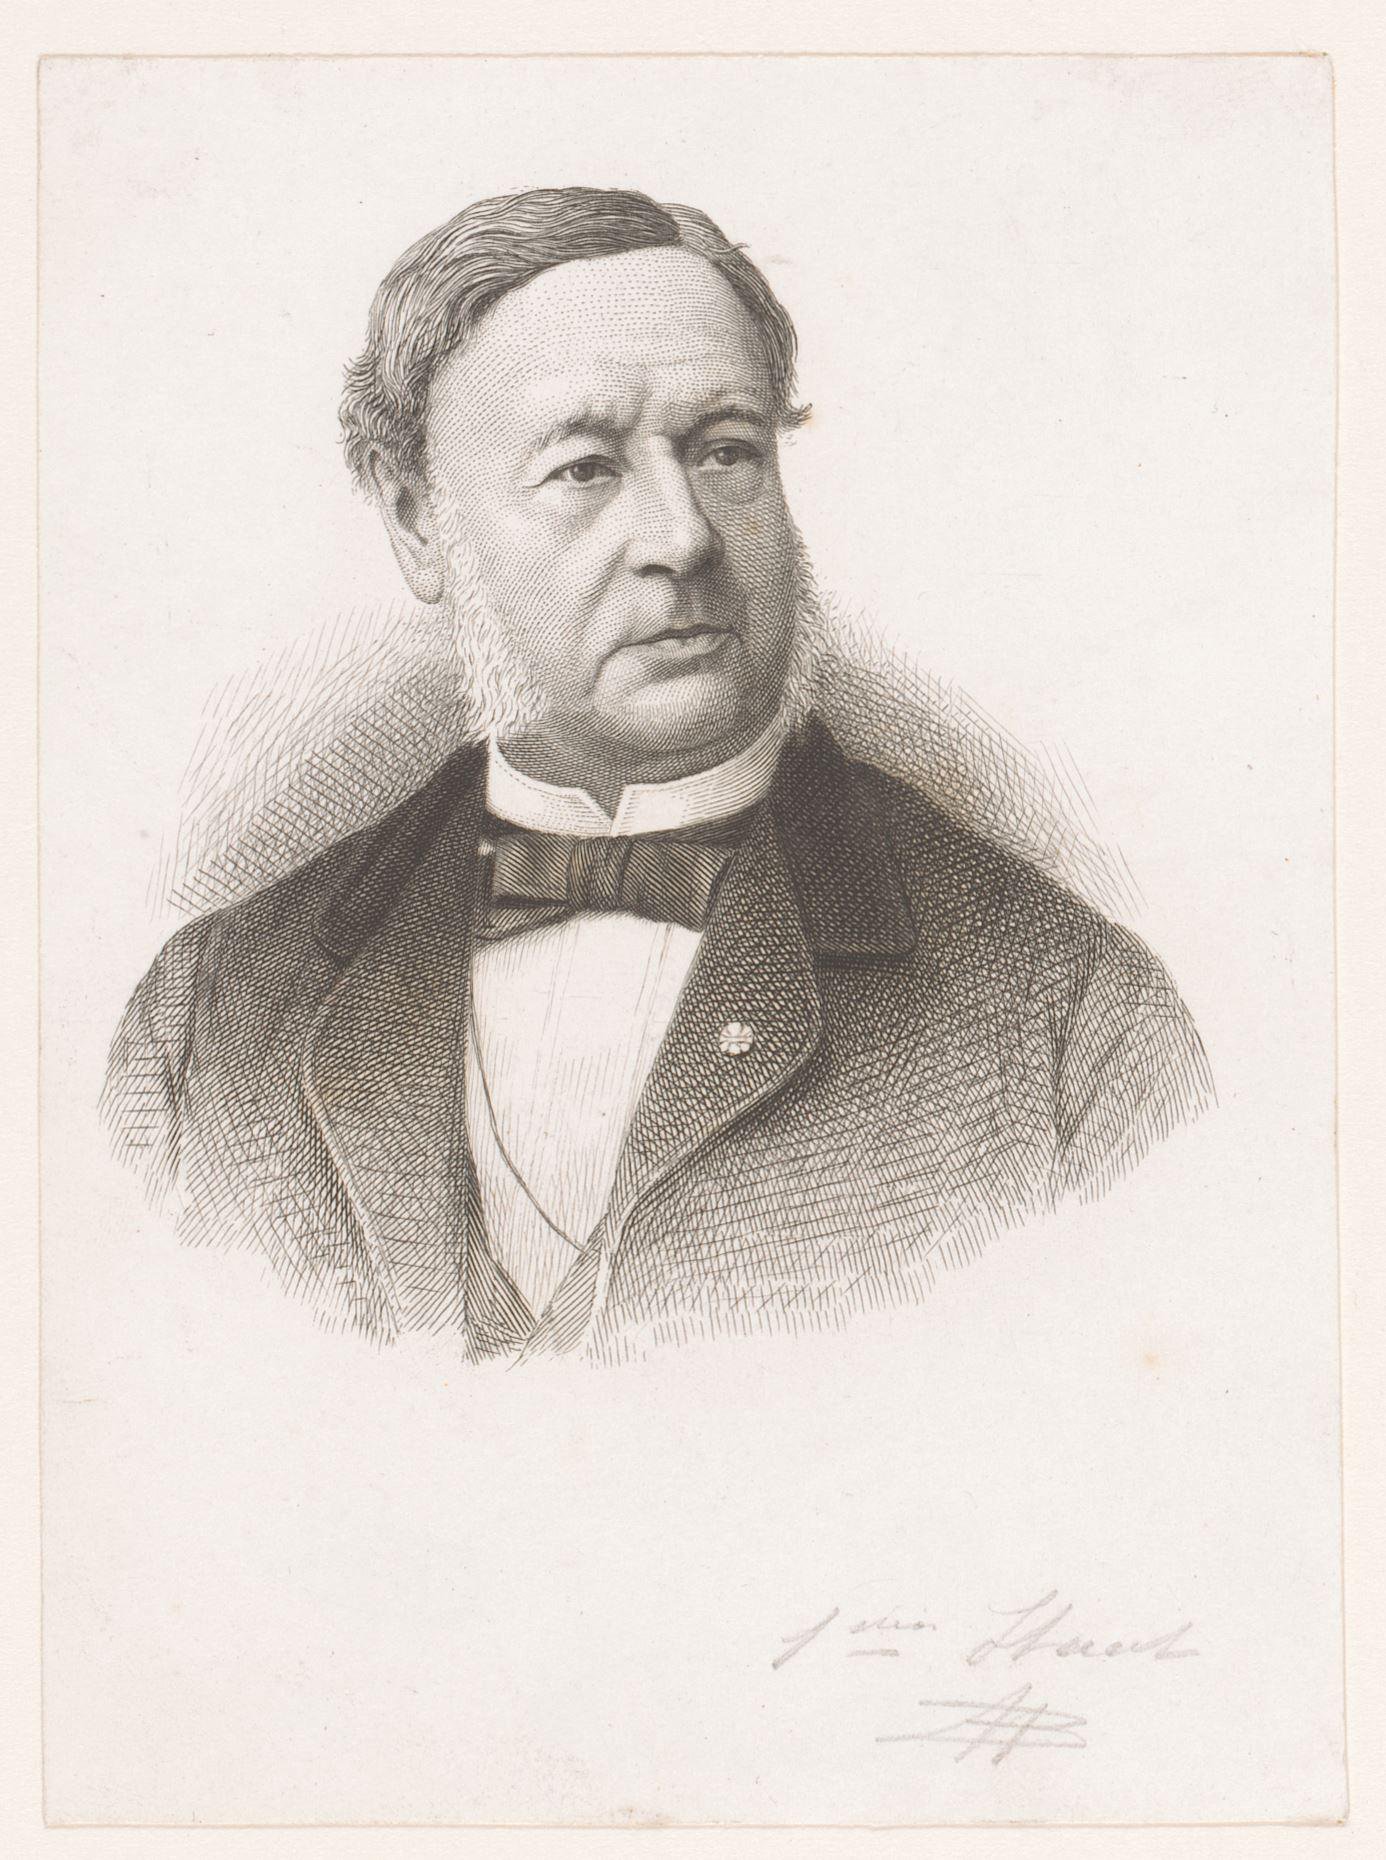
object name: print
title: Portret van een onbekende man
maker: jean baptiste pierre michiels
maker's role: print maker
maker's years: 1821-1890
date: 1831-1890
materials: paper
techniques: etching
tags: adult man, historical persons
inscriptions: collector's mark: Lugt 2228, inscription: ‘1em Staat’